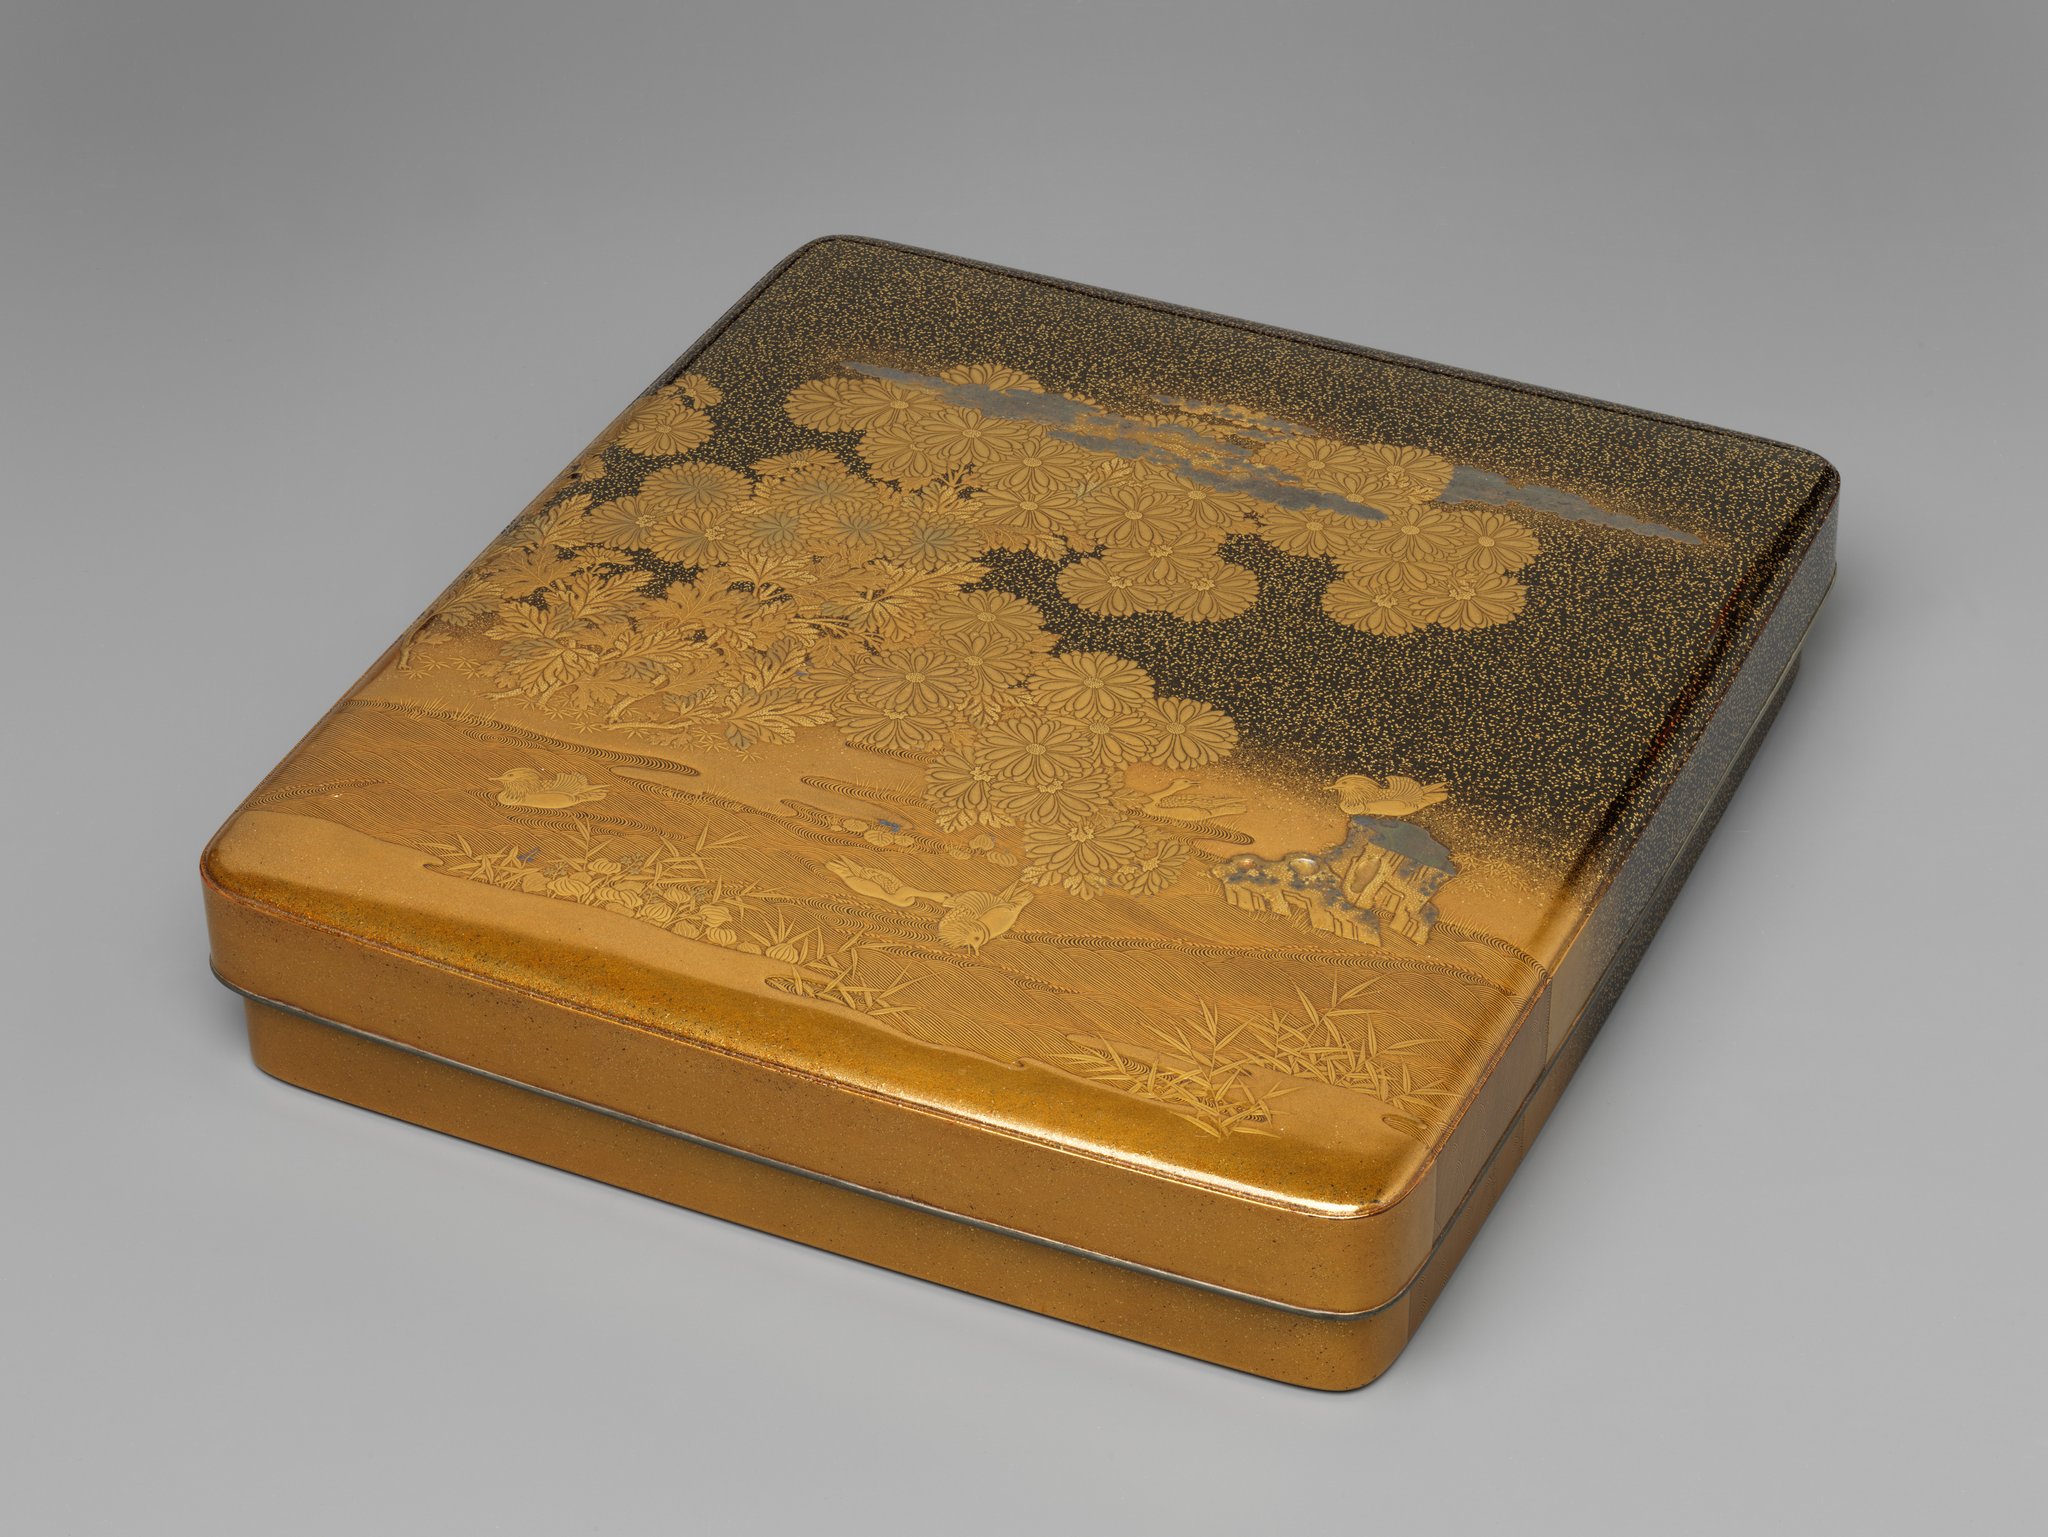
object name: writing box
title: Writing box (suzuribako) with chrysanthemums and mandarin ducks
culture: japanese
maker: igarashi fujin 五十嵐不尽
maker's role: artist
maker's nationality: japanese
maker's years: 1668-1733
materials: foil, gold, silver, wood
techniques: cutting, hiramakie, lacquer, maki-e